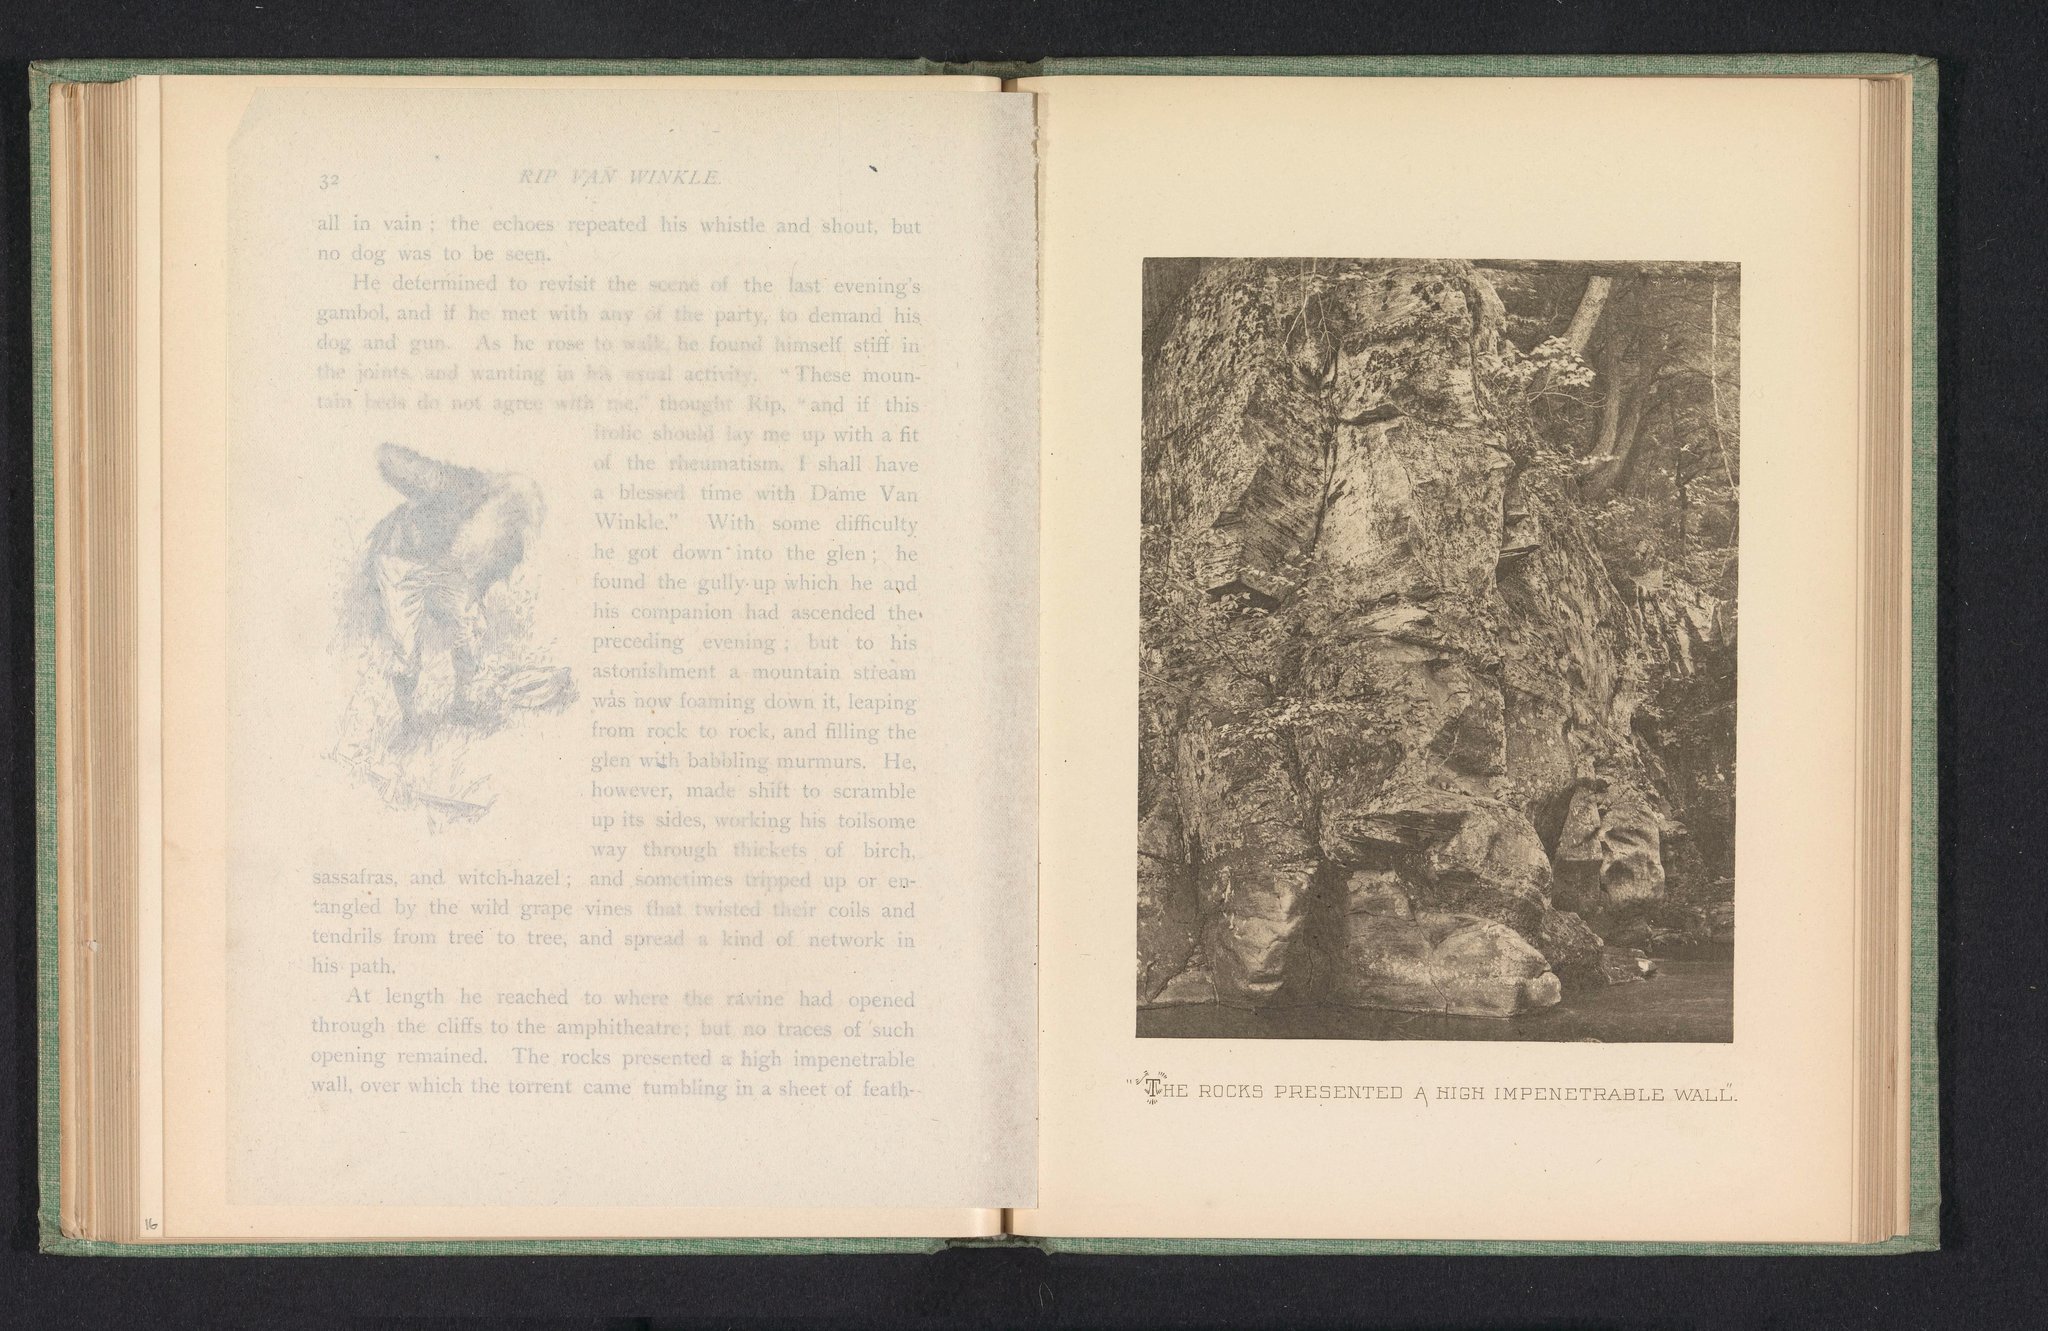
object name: photomechanical print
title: Gezicht op rotsen aan het water in het Catskillgebergte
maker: Anonymous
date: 1884-1894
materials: paper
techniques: photoaquatint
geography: catskill mountains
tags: river, rock-formations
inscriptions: inscription: ‘“The rocks presented a high impenetrable wall.”’